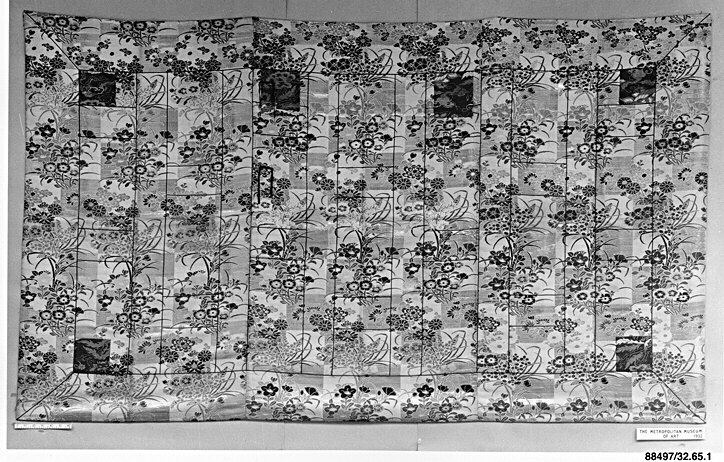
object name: robe, priest's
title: Priest's Robe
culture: japanese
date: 1801-1900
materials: silk